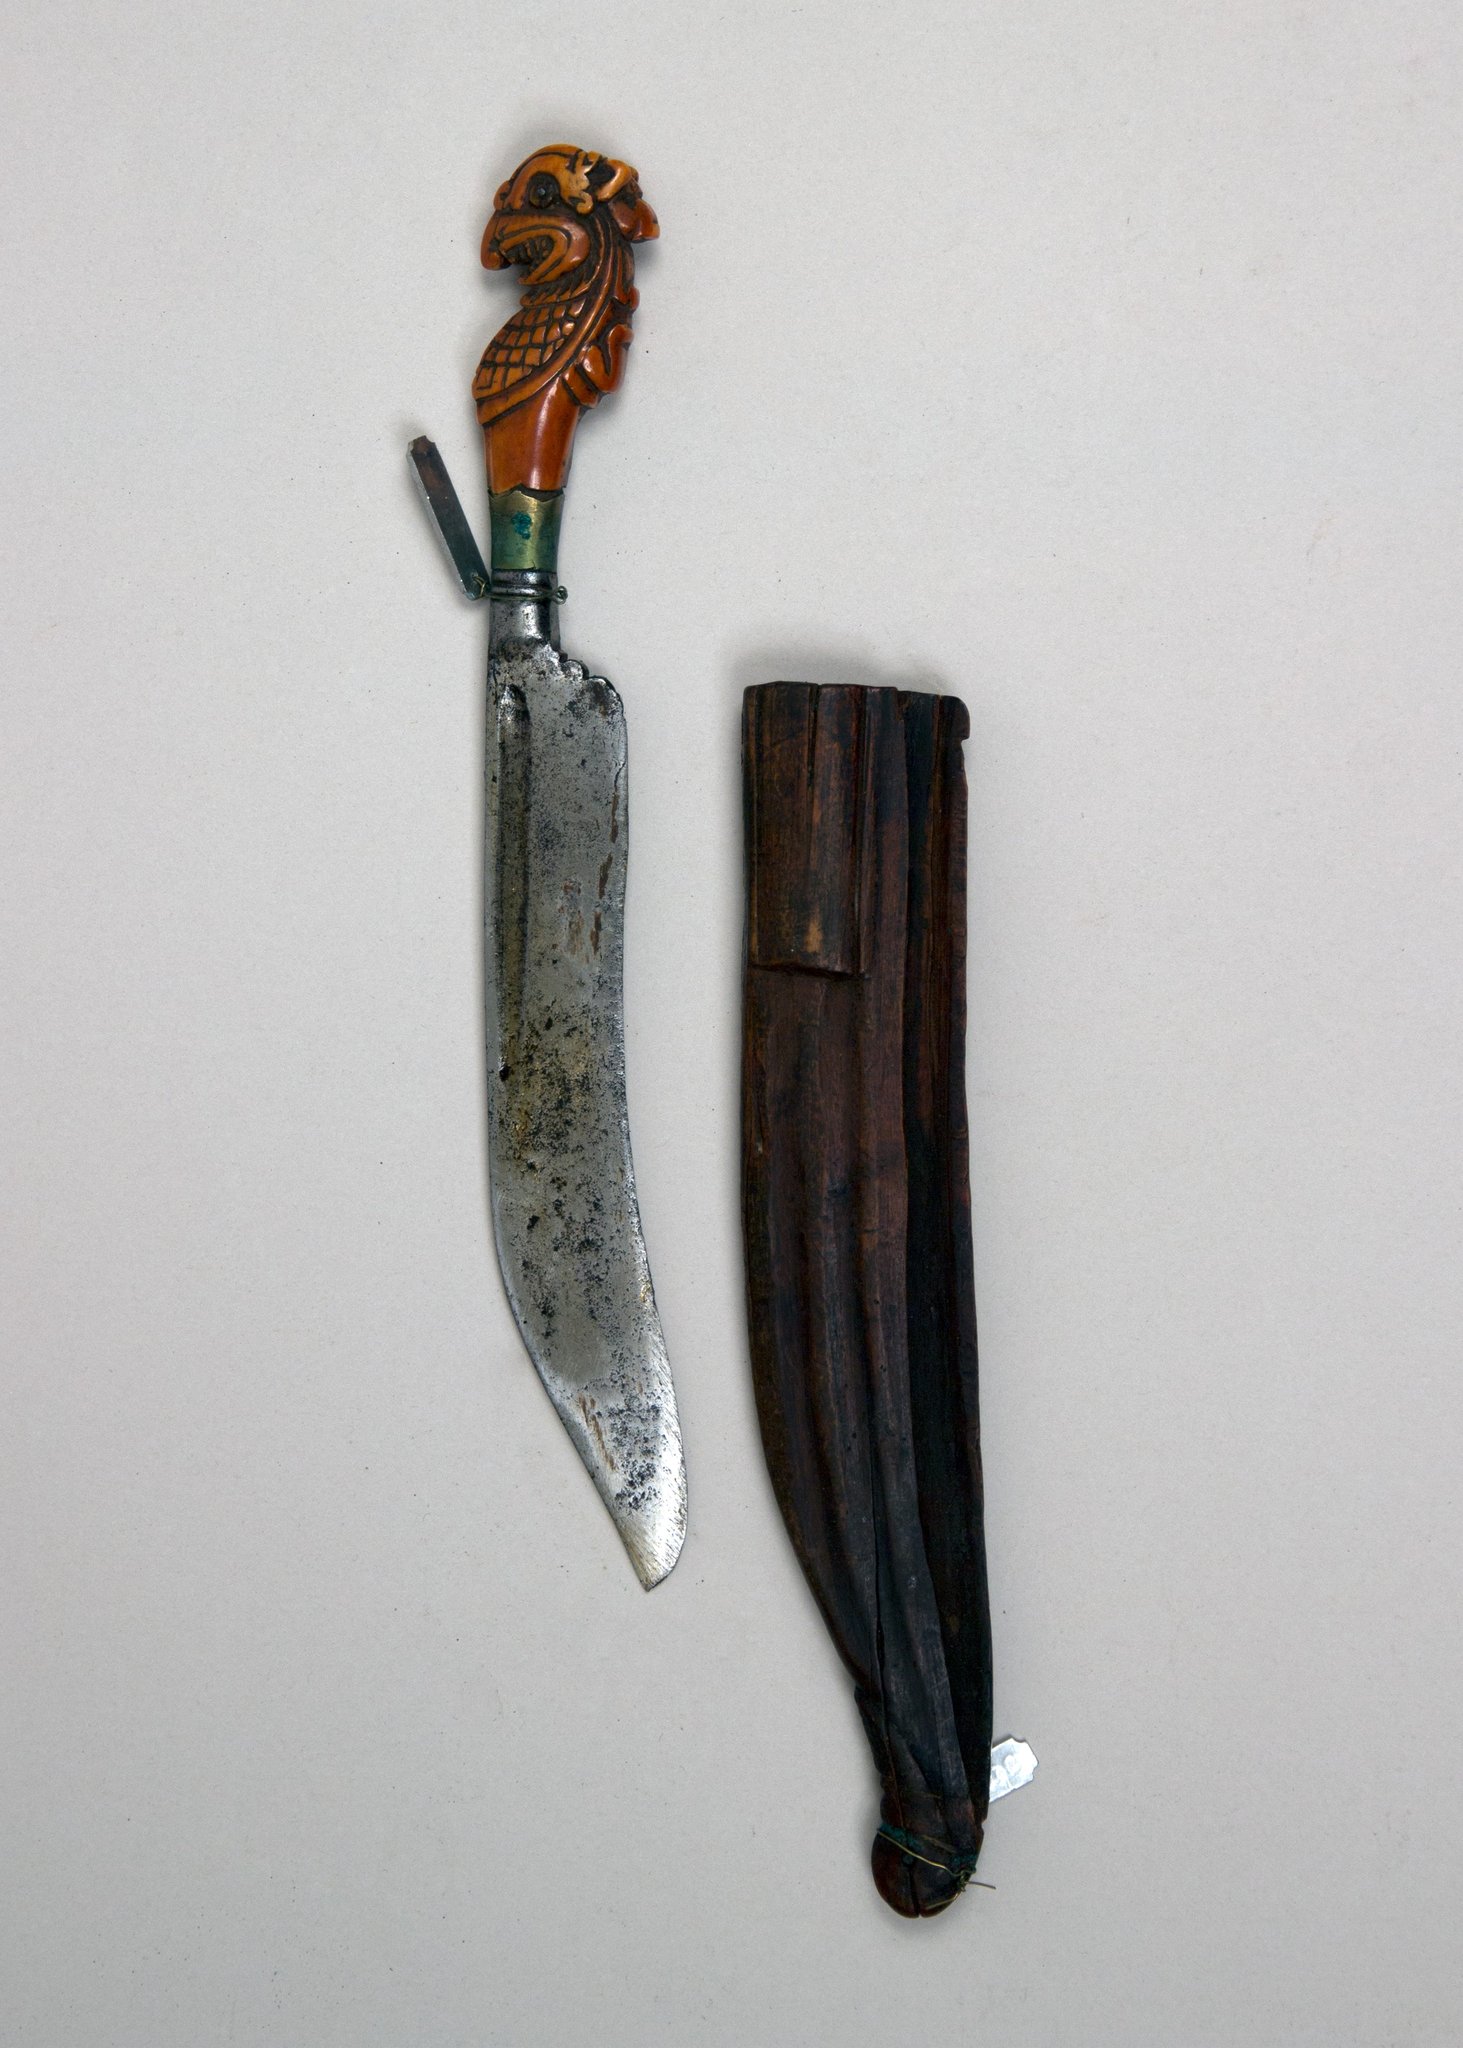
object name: knife piha kaetta with sheath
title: Knife (Phia Kaetta) with Sheath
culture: sri lankan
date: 1701-1900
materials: ivory, steel, wood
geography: sri lanka